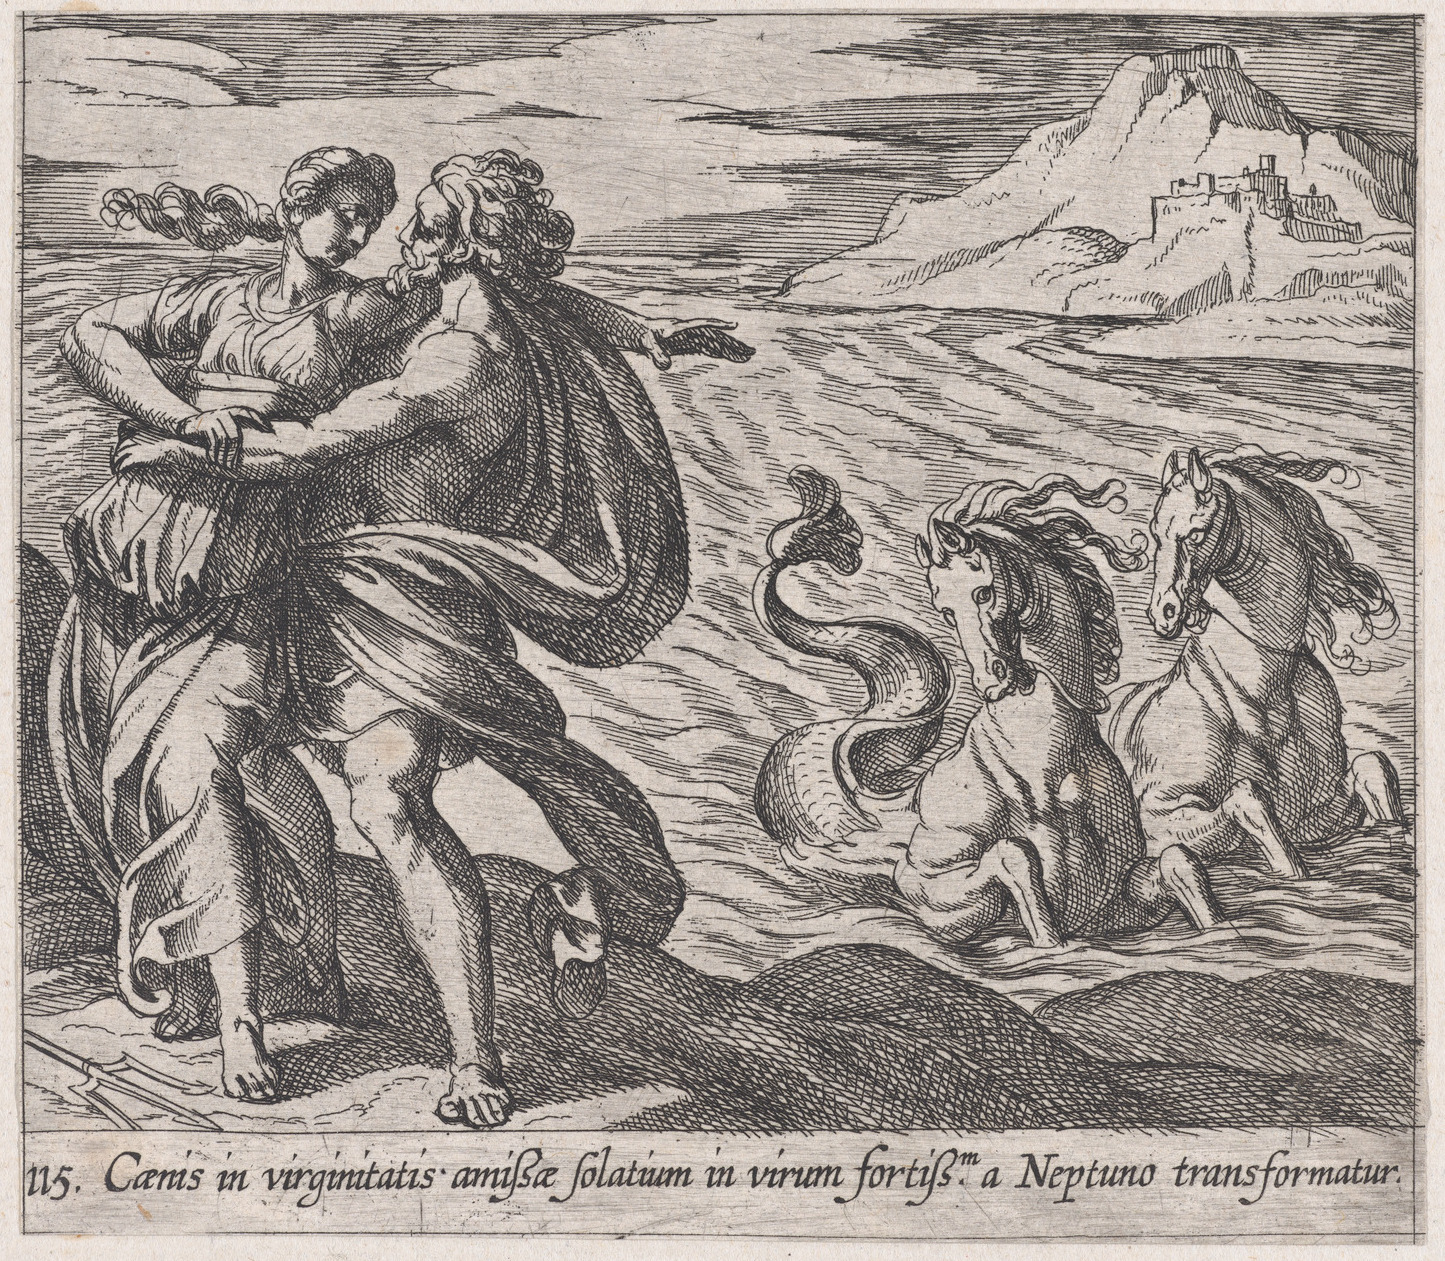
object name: print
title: Plate 115: The Rape of Caenis (Caenis in virginitatis amißae solatium in virum fortiß.m a Neptuno transformatur), from Ovid's 'Metamorphoses'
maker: antonio tempesta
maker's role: artist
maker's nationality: italian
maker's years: 1555-1630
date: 1606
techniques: etching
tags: men,women,mountains